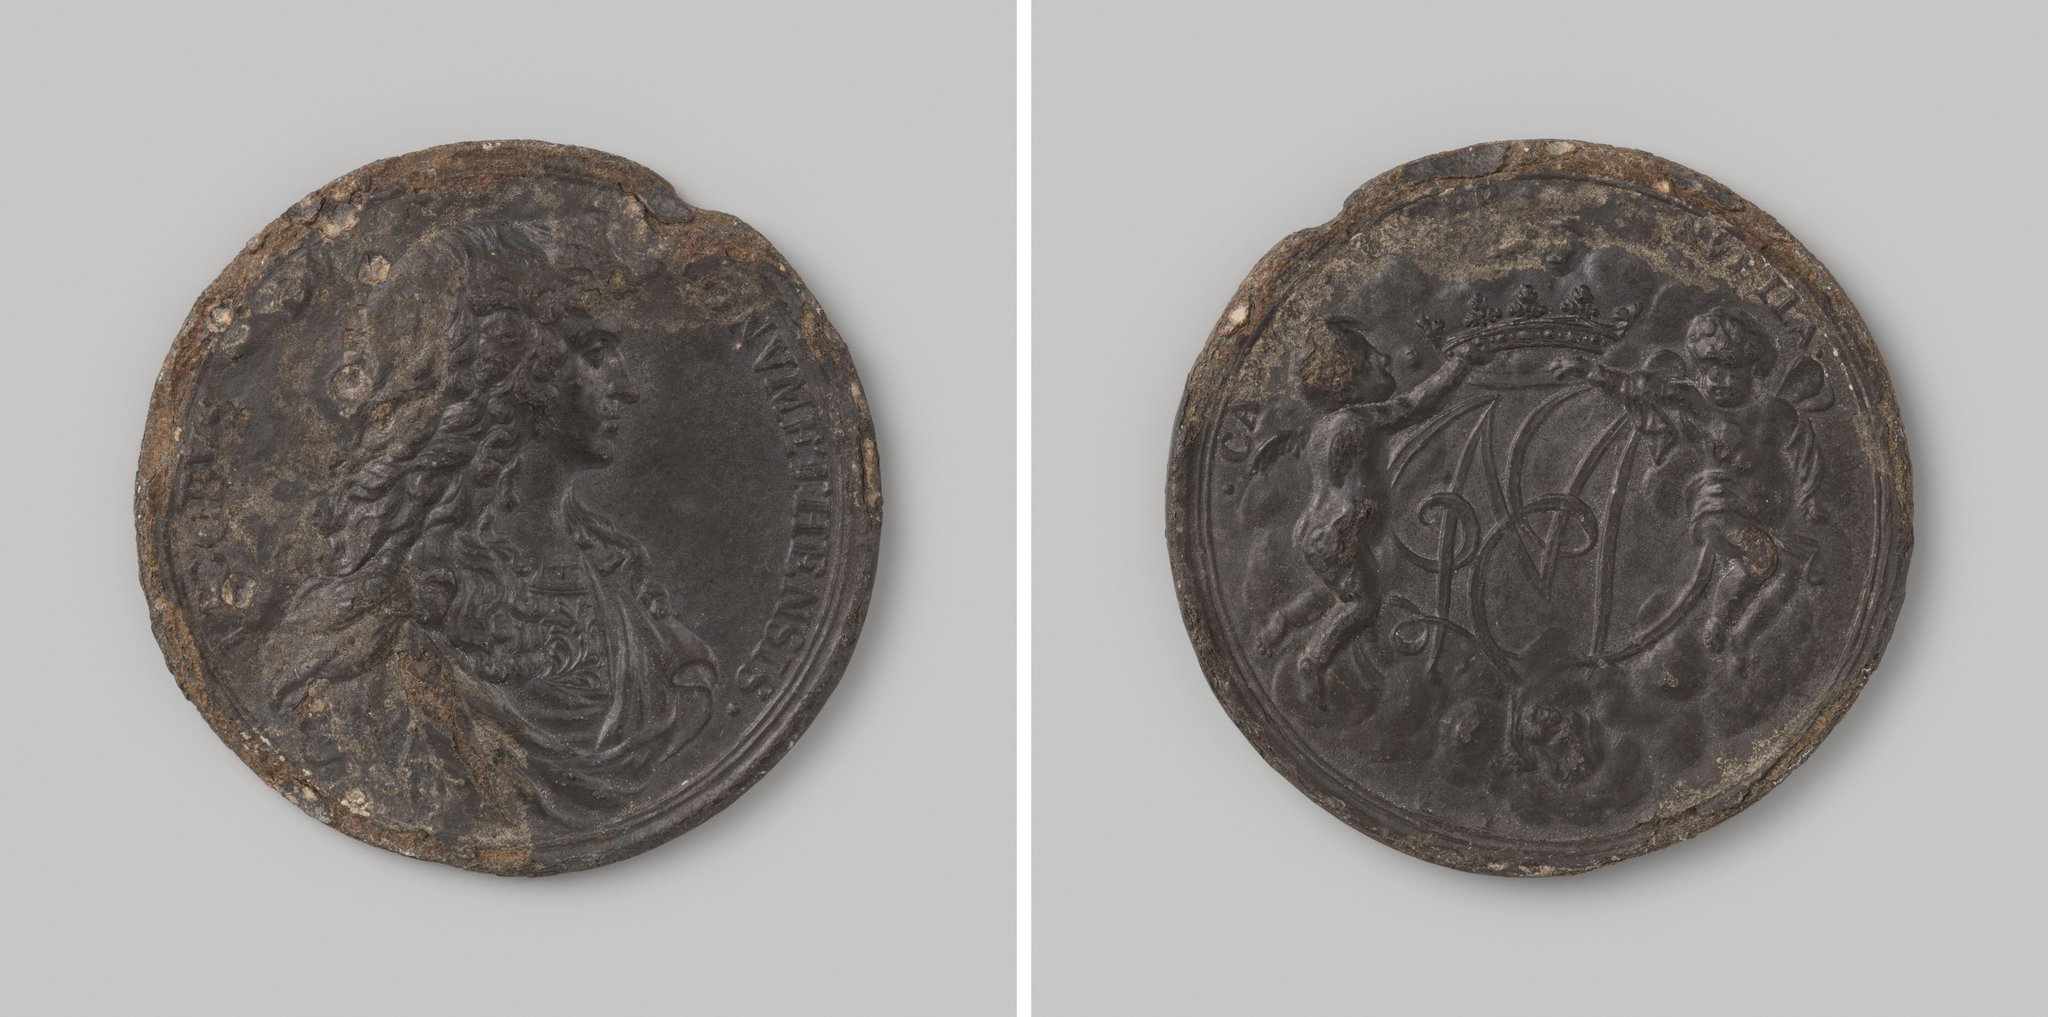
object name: history medal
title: Onthoofding van James Scott hertog van Monmouth in Londen 1685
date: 1685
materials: tin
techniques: striking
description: Tinnen penning, deels gecorrodeerd, op de voorzijde het borstbeeld van Koning Jacobus naar rechts met omschrift, op de keerzijde twee engelen in de wolken die een kroon aanbrengen boven een monogram.